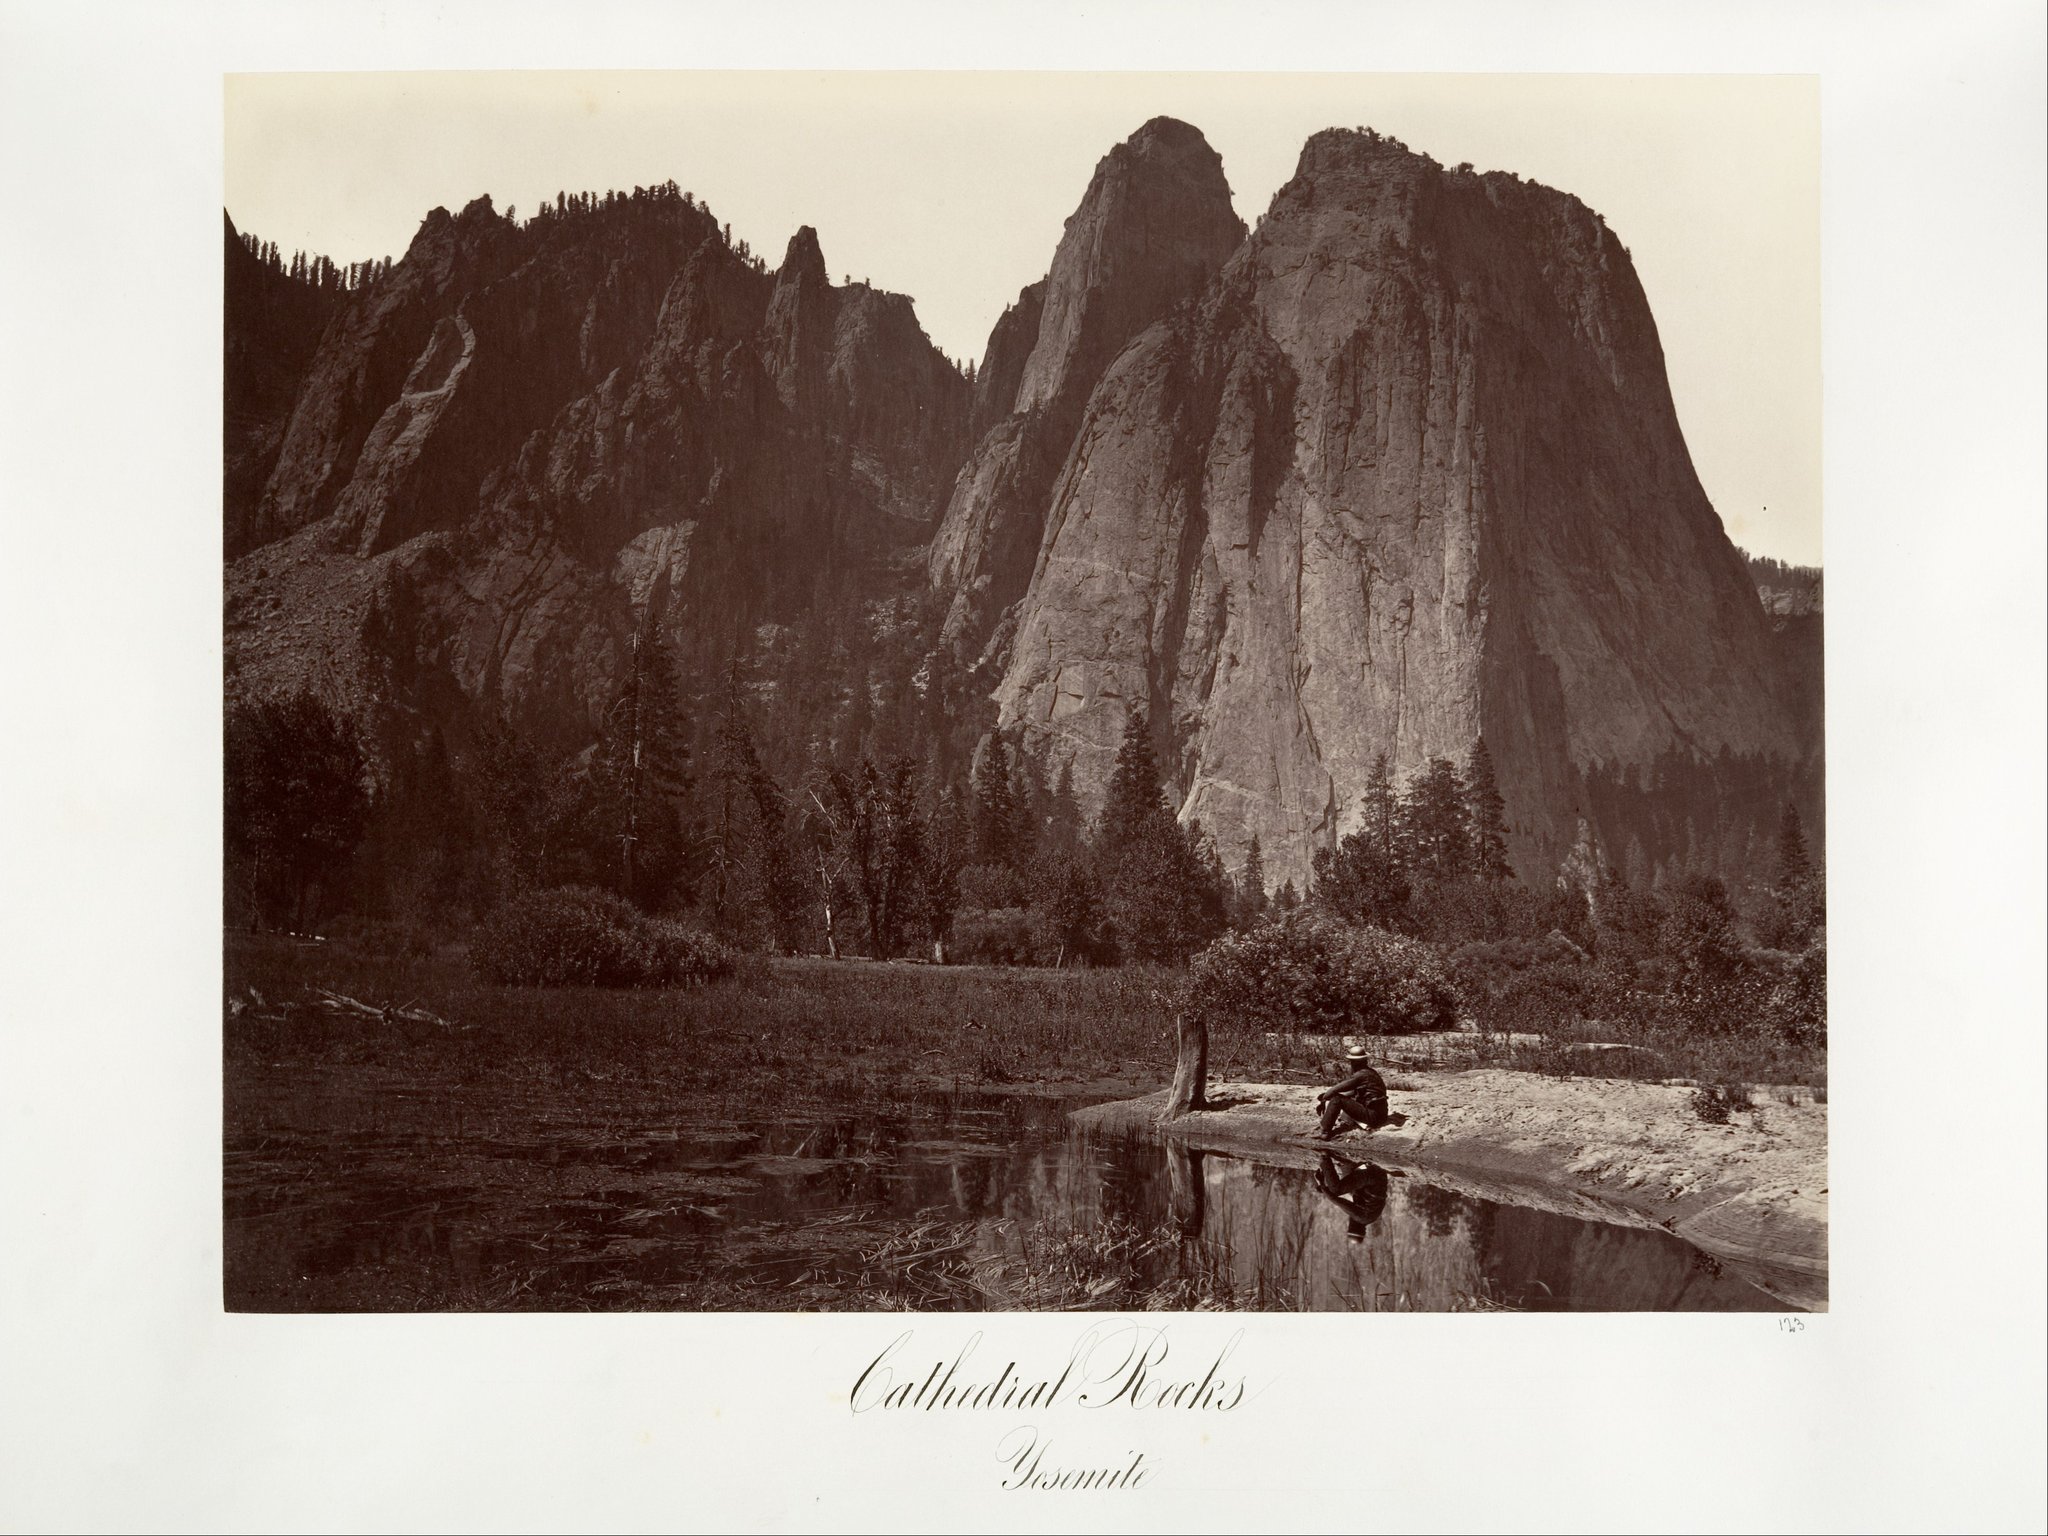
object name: photograph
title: Cathedral Rocks, Yosemite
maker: carleton e. watkins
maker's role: artist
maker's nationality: american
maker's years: 1829-1916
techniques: albumen silver print, glass negative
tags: mountains,landscapes